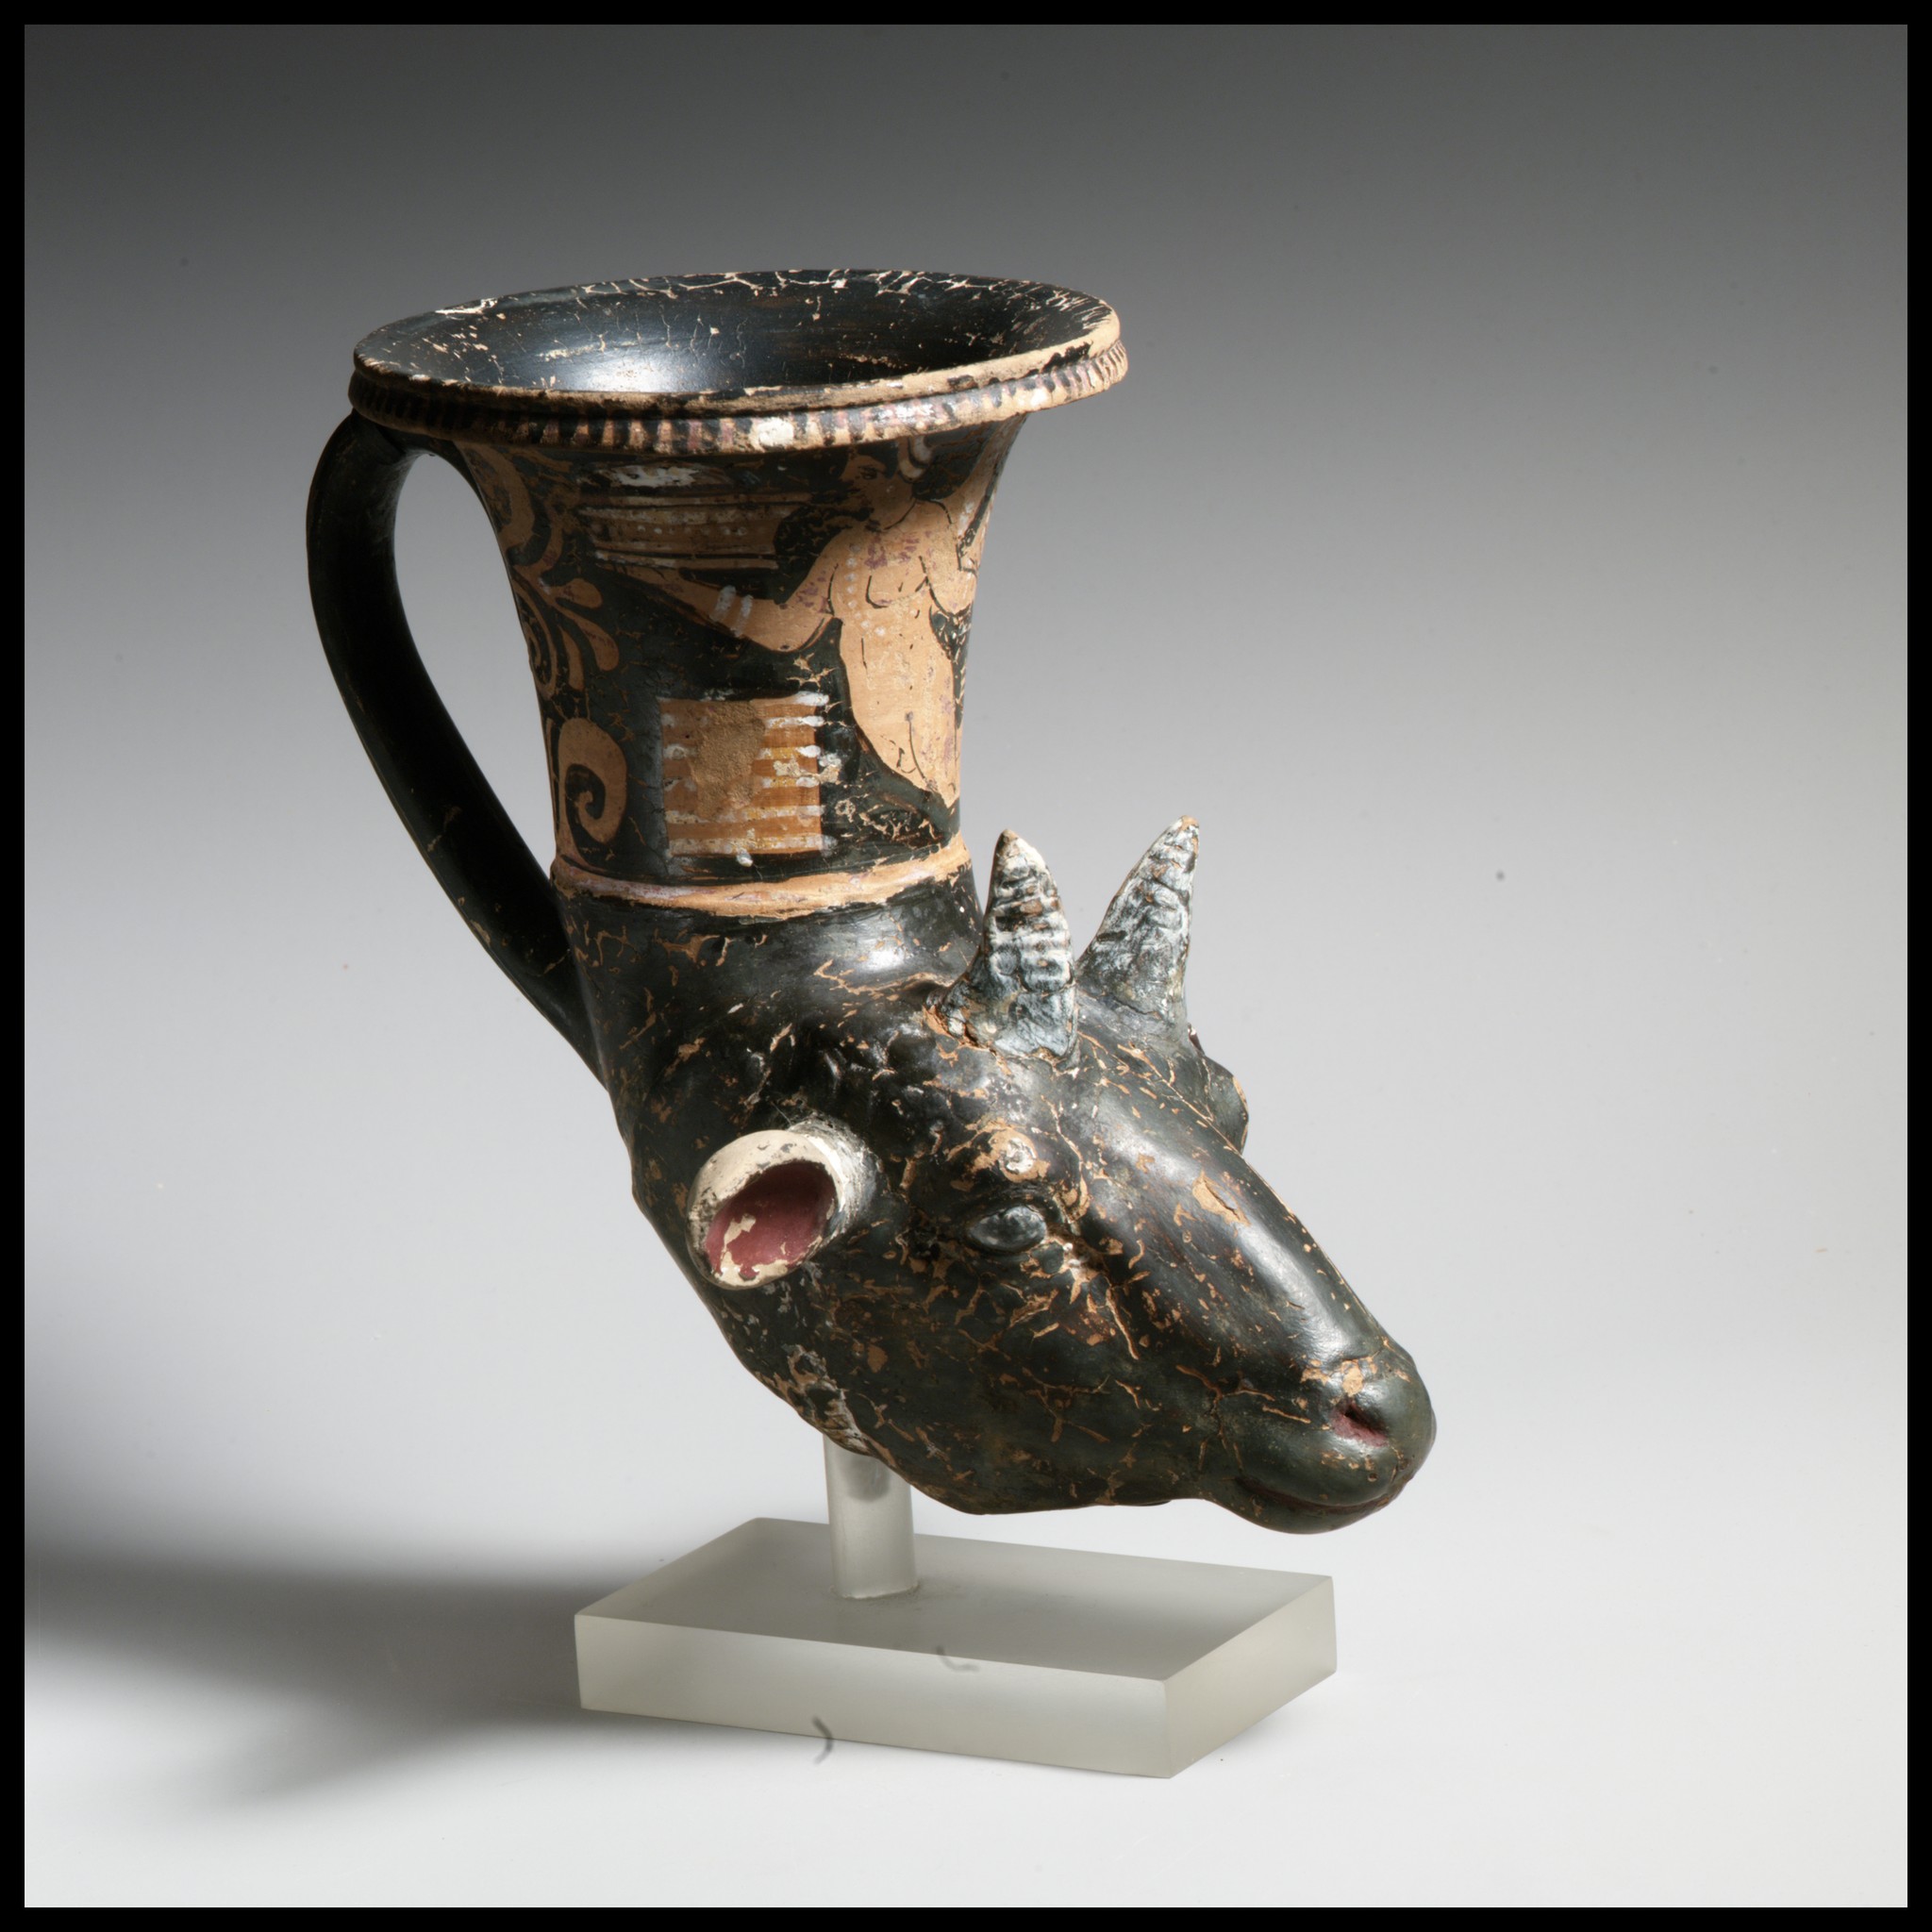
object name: rhyton in the form of a sheep's head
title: Terracotta rhyton (vase for libations or drinking)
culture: greek, south italian, apulian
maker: patera-ganymede workshop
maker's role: artist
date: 350-300 BCE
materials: terracotta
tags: eros,sheep